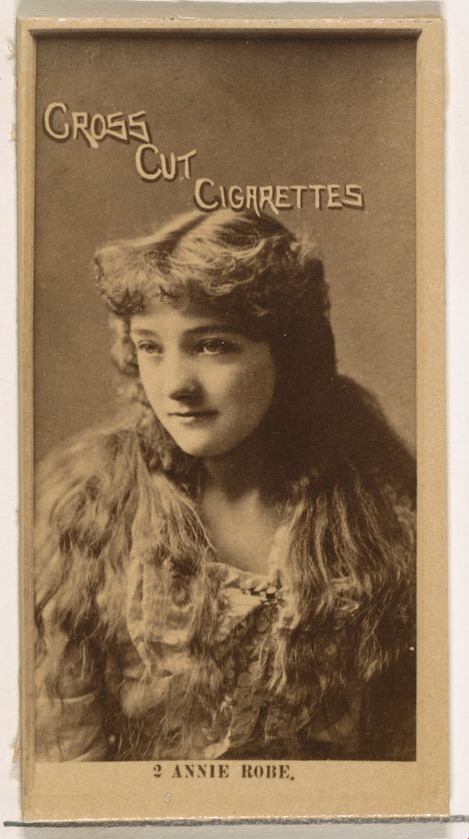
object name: print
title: Card Number 2, Annie Robe, from the Actors and Actresses series (N145-2) issued by Duke Sons & Co. to promote Cross Cut Cigarettes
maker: w. duke, sons & co.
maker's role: publisher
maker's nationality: american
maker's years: 1870-1920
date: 1880-1889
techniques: albumen silver print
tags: portraits,women,actresses